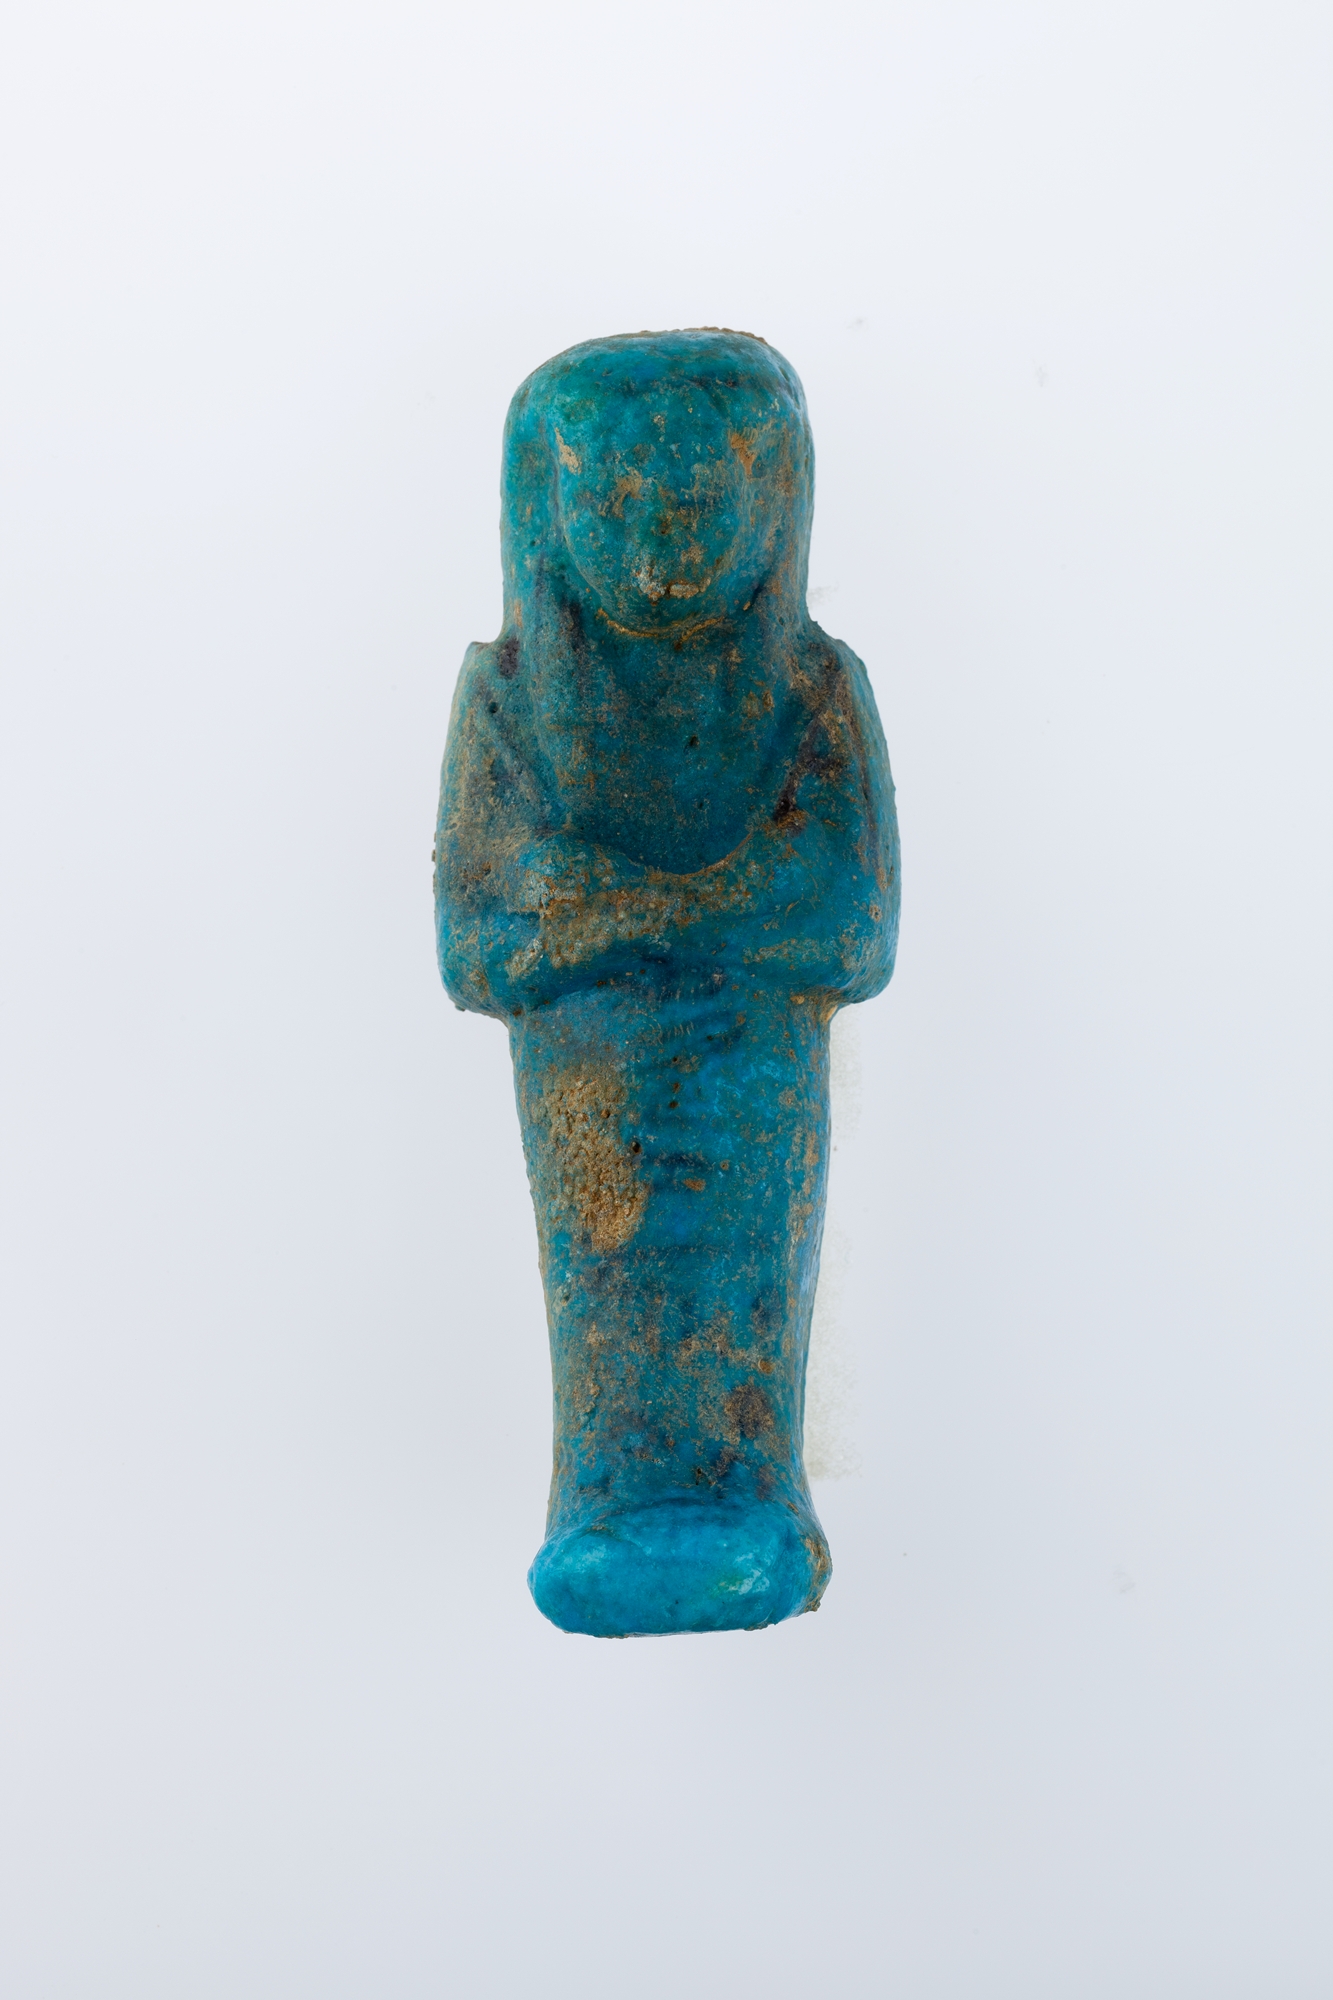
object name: shabti, henettawy c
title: Worker Shabti of Henettawy (C), Daughter of Isetemkheb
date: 990-970 BCE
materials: faience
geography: egypt